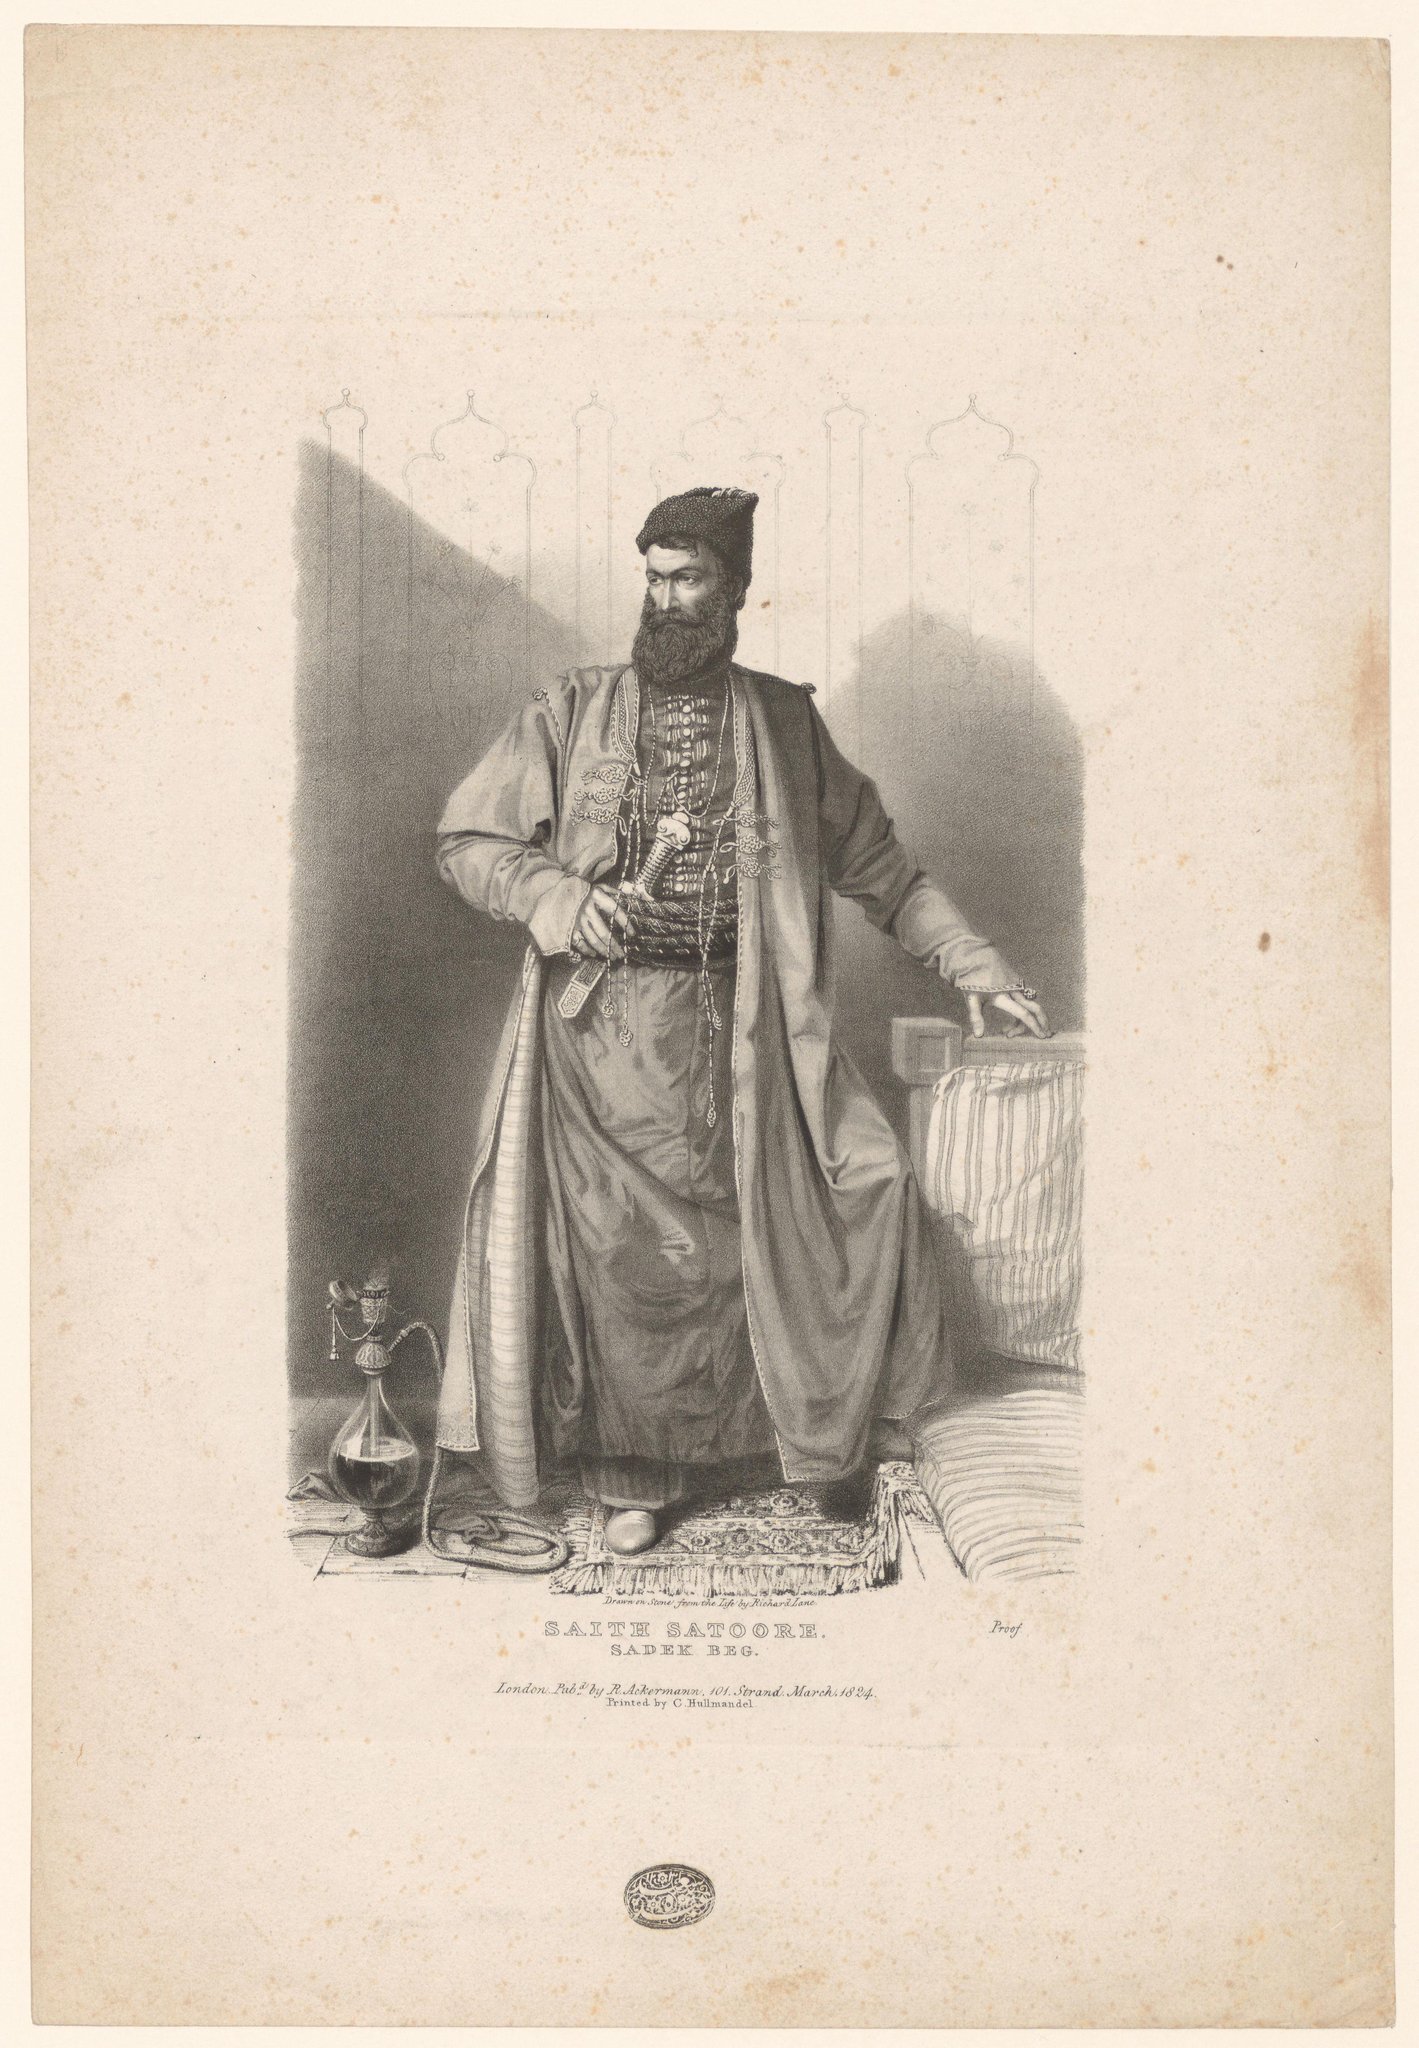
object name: print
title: Portret van Saith Satoor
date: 1824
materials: paper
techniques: lithograph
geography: london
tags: adult man, historical persons, beard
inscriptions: collector's mark: Lugt 2228, mark